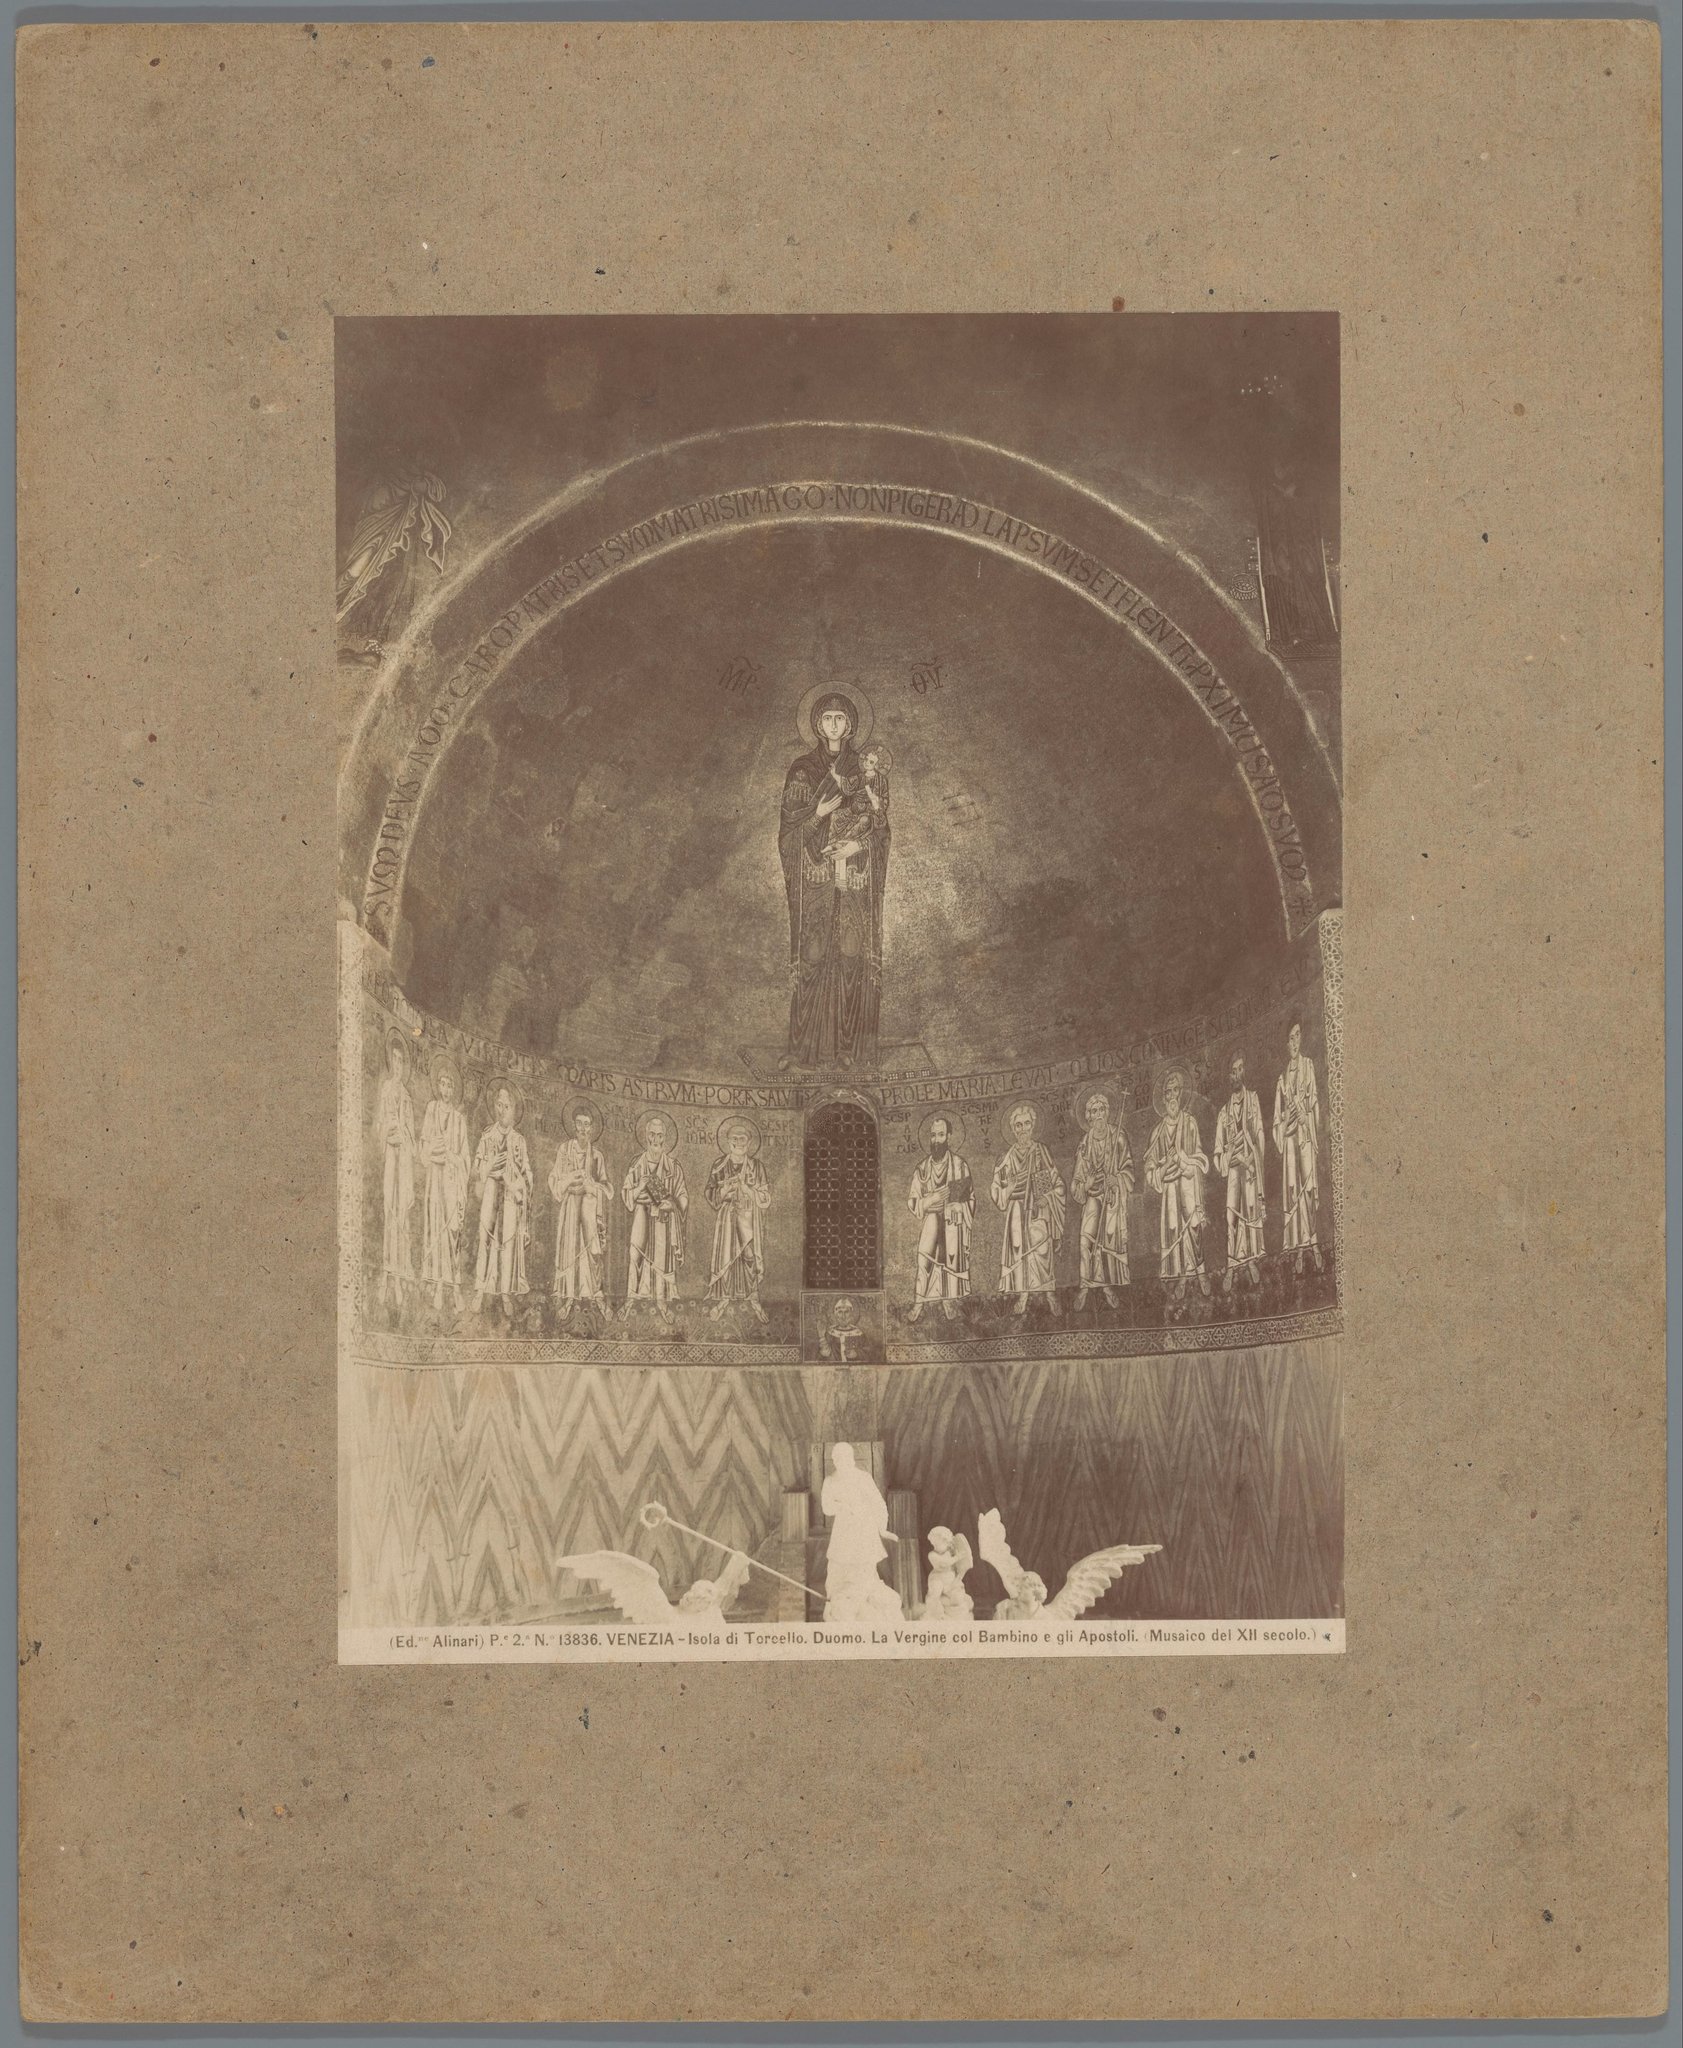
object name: photograph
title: VENEZIA - Isola di Torcello. Duomo. La Vergine col Bambino e gli Apostoli.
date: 1875-1900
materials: cardboard, photographic support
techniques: albumen print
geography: cathedral of santa maria assunta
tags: madonna: i.e. mary with the christ-child, art (+ mosaic making), the twelve apostles (as a group), usually with books or scrolls (not in biblical context), parts of church interior: choir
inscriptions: collector's mark: Lugt 3937, number: ‘P.e 2.a N.o 13836.’